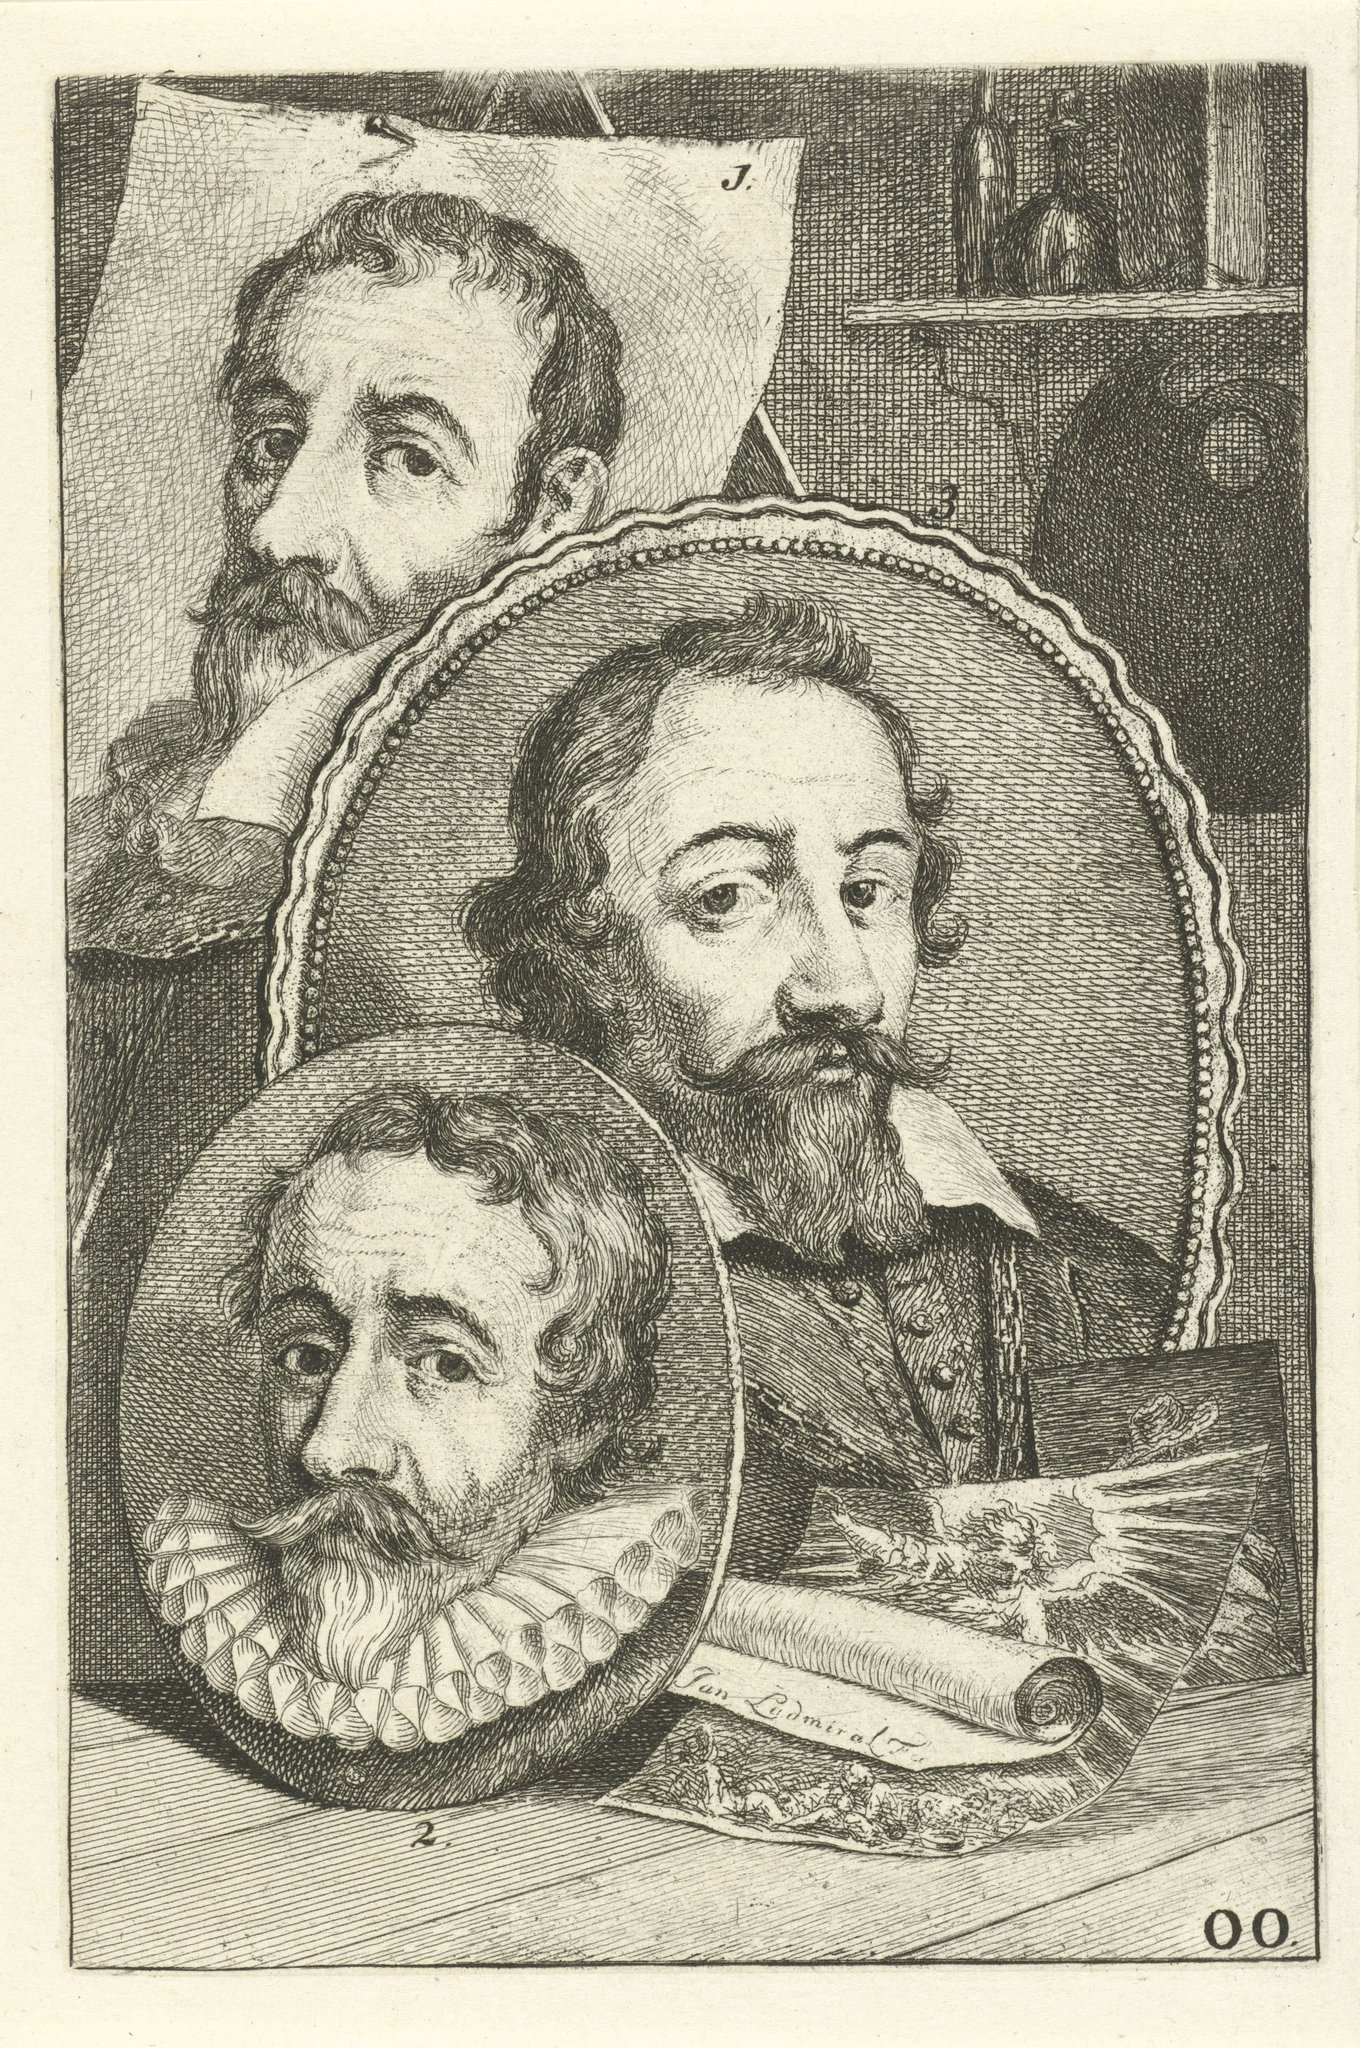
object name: book illustration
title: Portretten van Johann I, Rafael en Aegidius Sadeler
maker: jan l admiral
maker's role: draughtsman, print maker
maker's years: 1699-1773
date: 1764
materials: paper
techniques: etching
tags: antwerp, prague, draughtsman, aegidius sadeler (ii), brussels, venice, johann sadeler (i)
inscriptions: collector's mark: Lugt 2228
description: Prent opgenomen in: Mander, Karel van; Jongh, Jacobus de (vert.). Het leven der doorluchtige Nederlandsche en eenige Hoogduitsche schilders. Amsterdam: Steven van Esveldt, 1764.